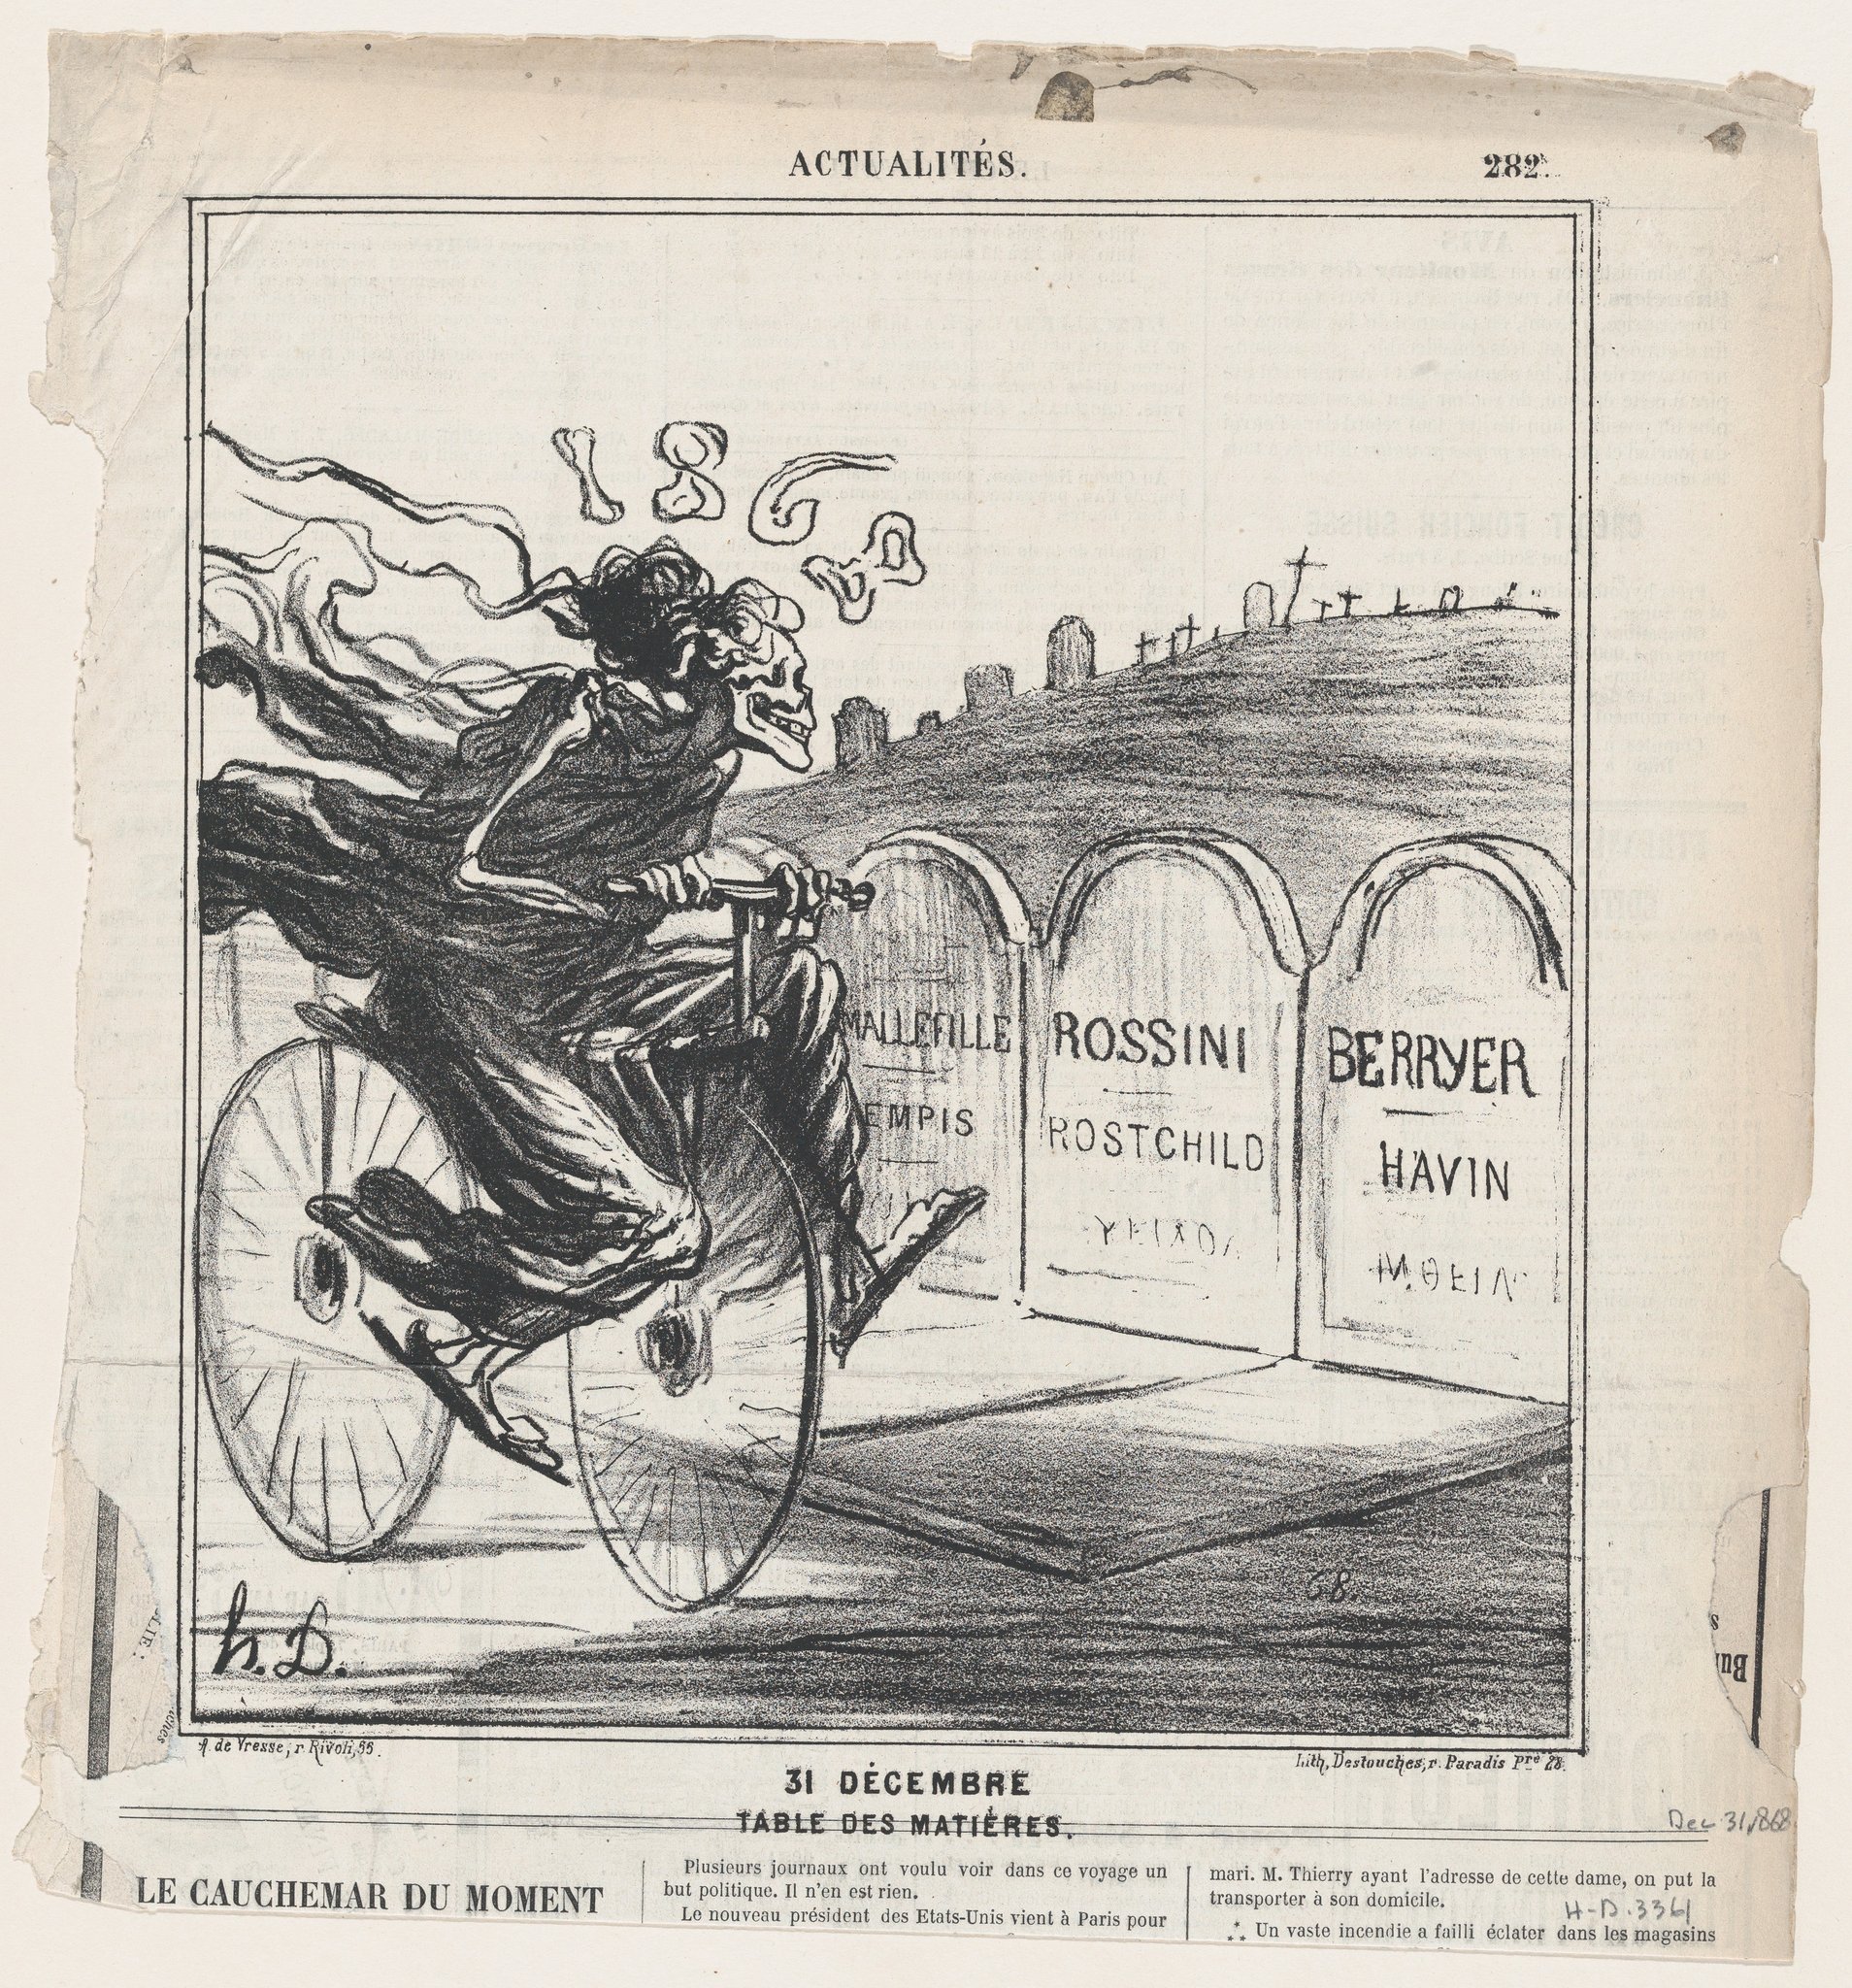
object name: print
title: December 31st, Table of contents, from 'News of the day,' published in Le Charivari, December 31, 1868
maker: honoré daumier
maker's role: artist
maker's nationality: french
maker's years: 1808-1879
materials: paper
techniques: lithograph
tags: satire,skeletons,bicycles